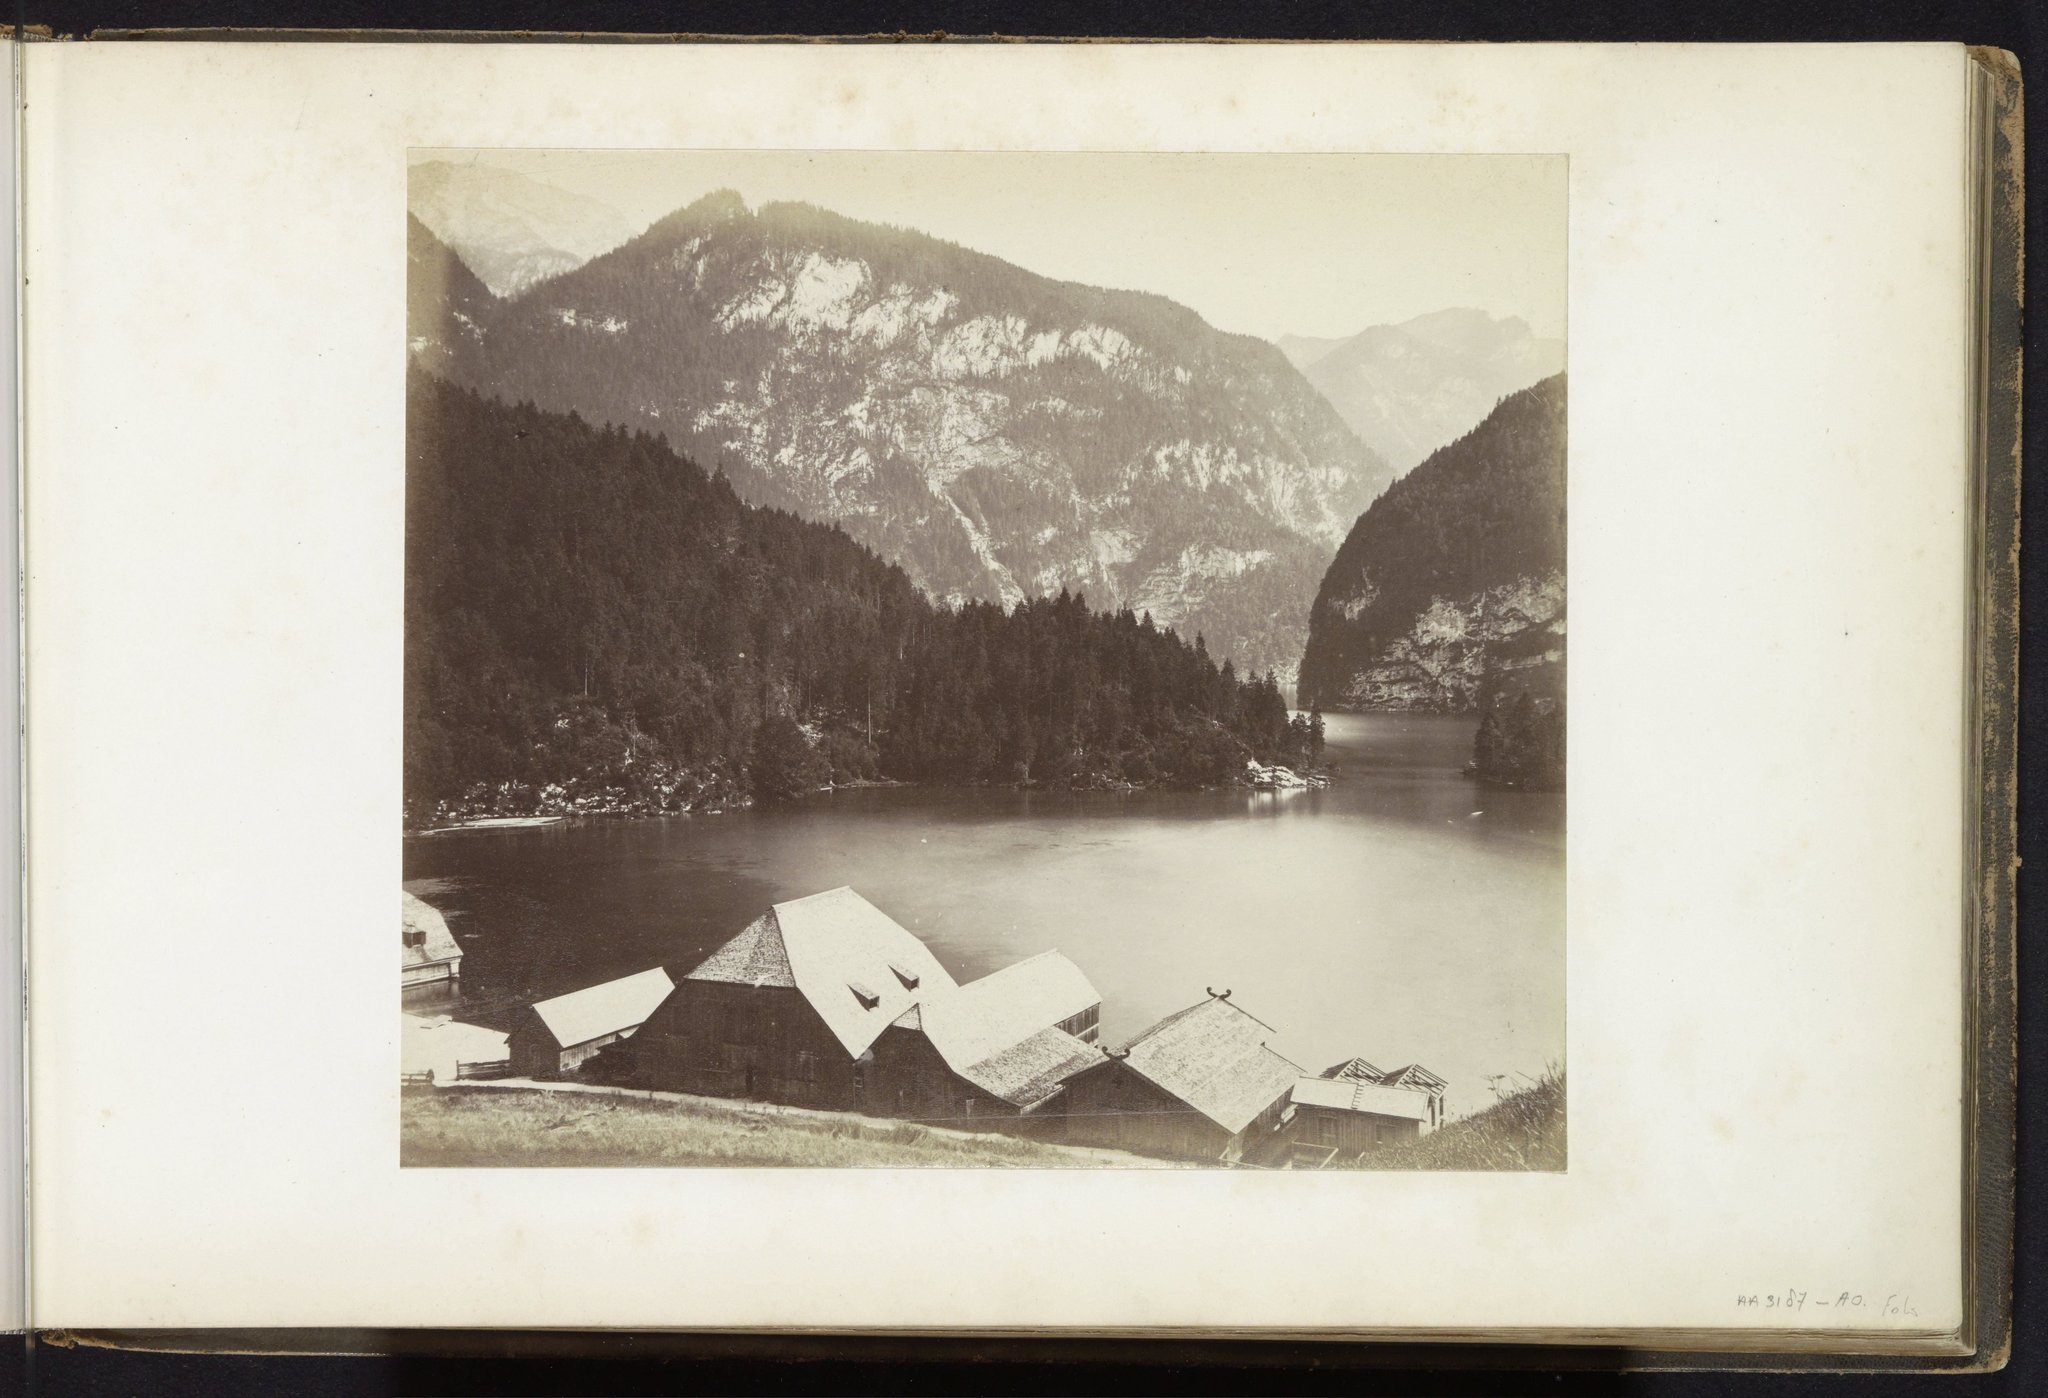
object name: photograph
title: Gezicht op een bergmeer met gebouwen op de oever, mogelijk in de Alpen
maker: Anonymous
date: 1865-1875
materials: photographic support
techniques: albumen print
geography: alps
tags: lake, mountains (+ landscape with figures, staffage)